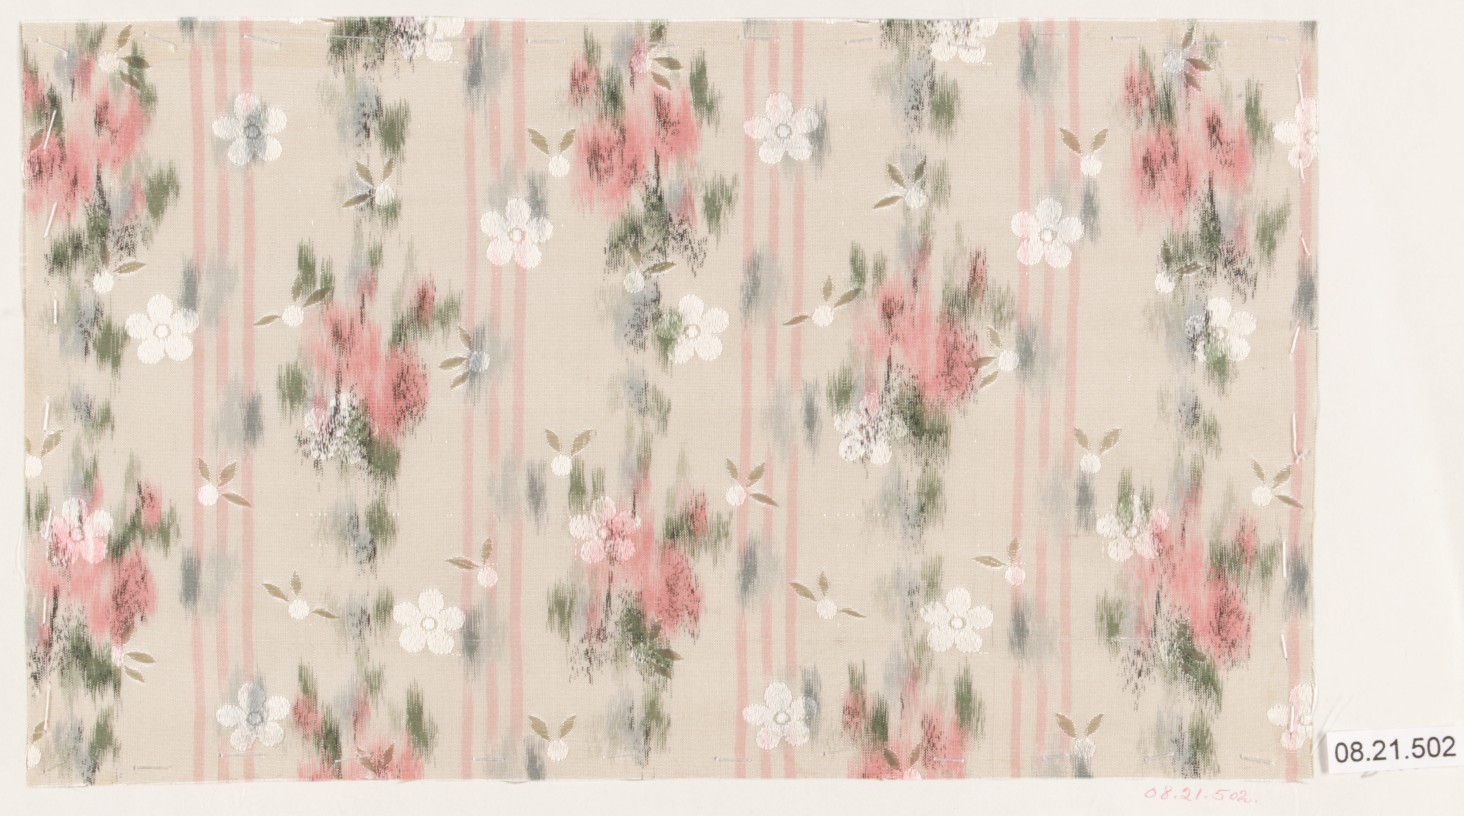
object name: textile sample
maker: Anonymous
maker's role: designer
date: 1900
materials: silk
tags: flowers